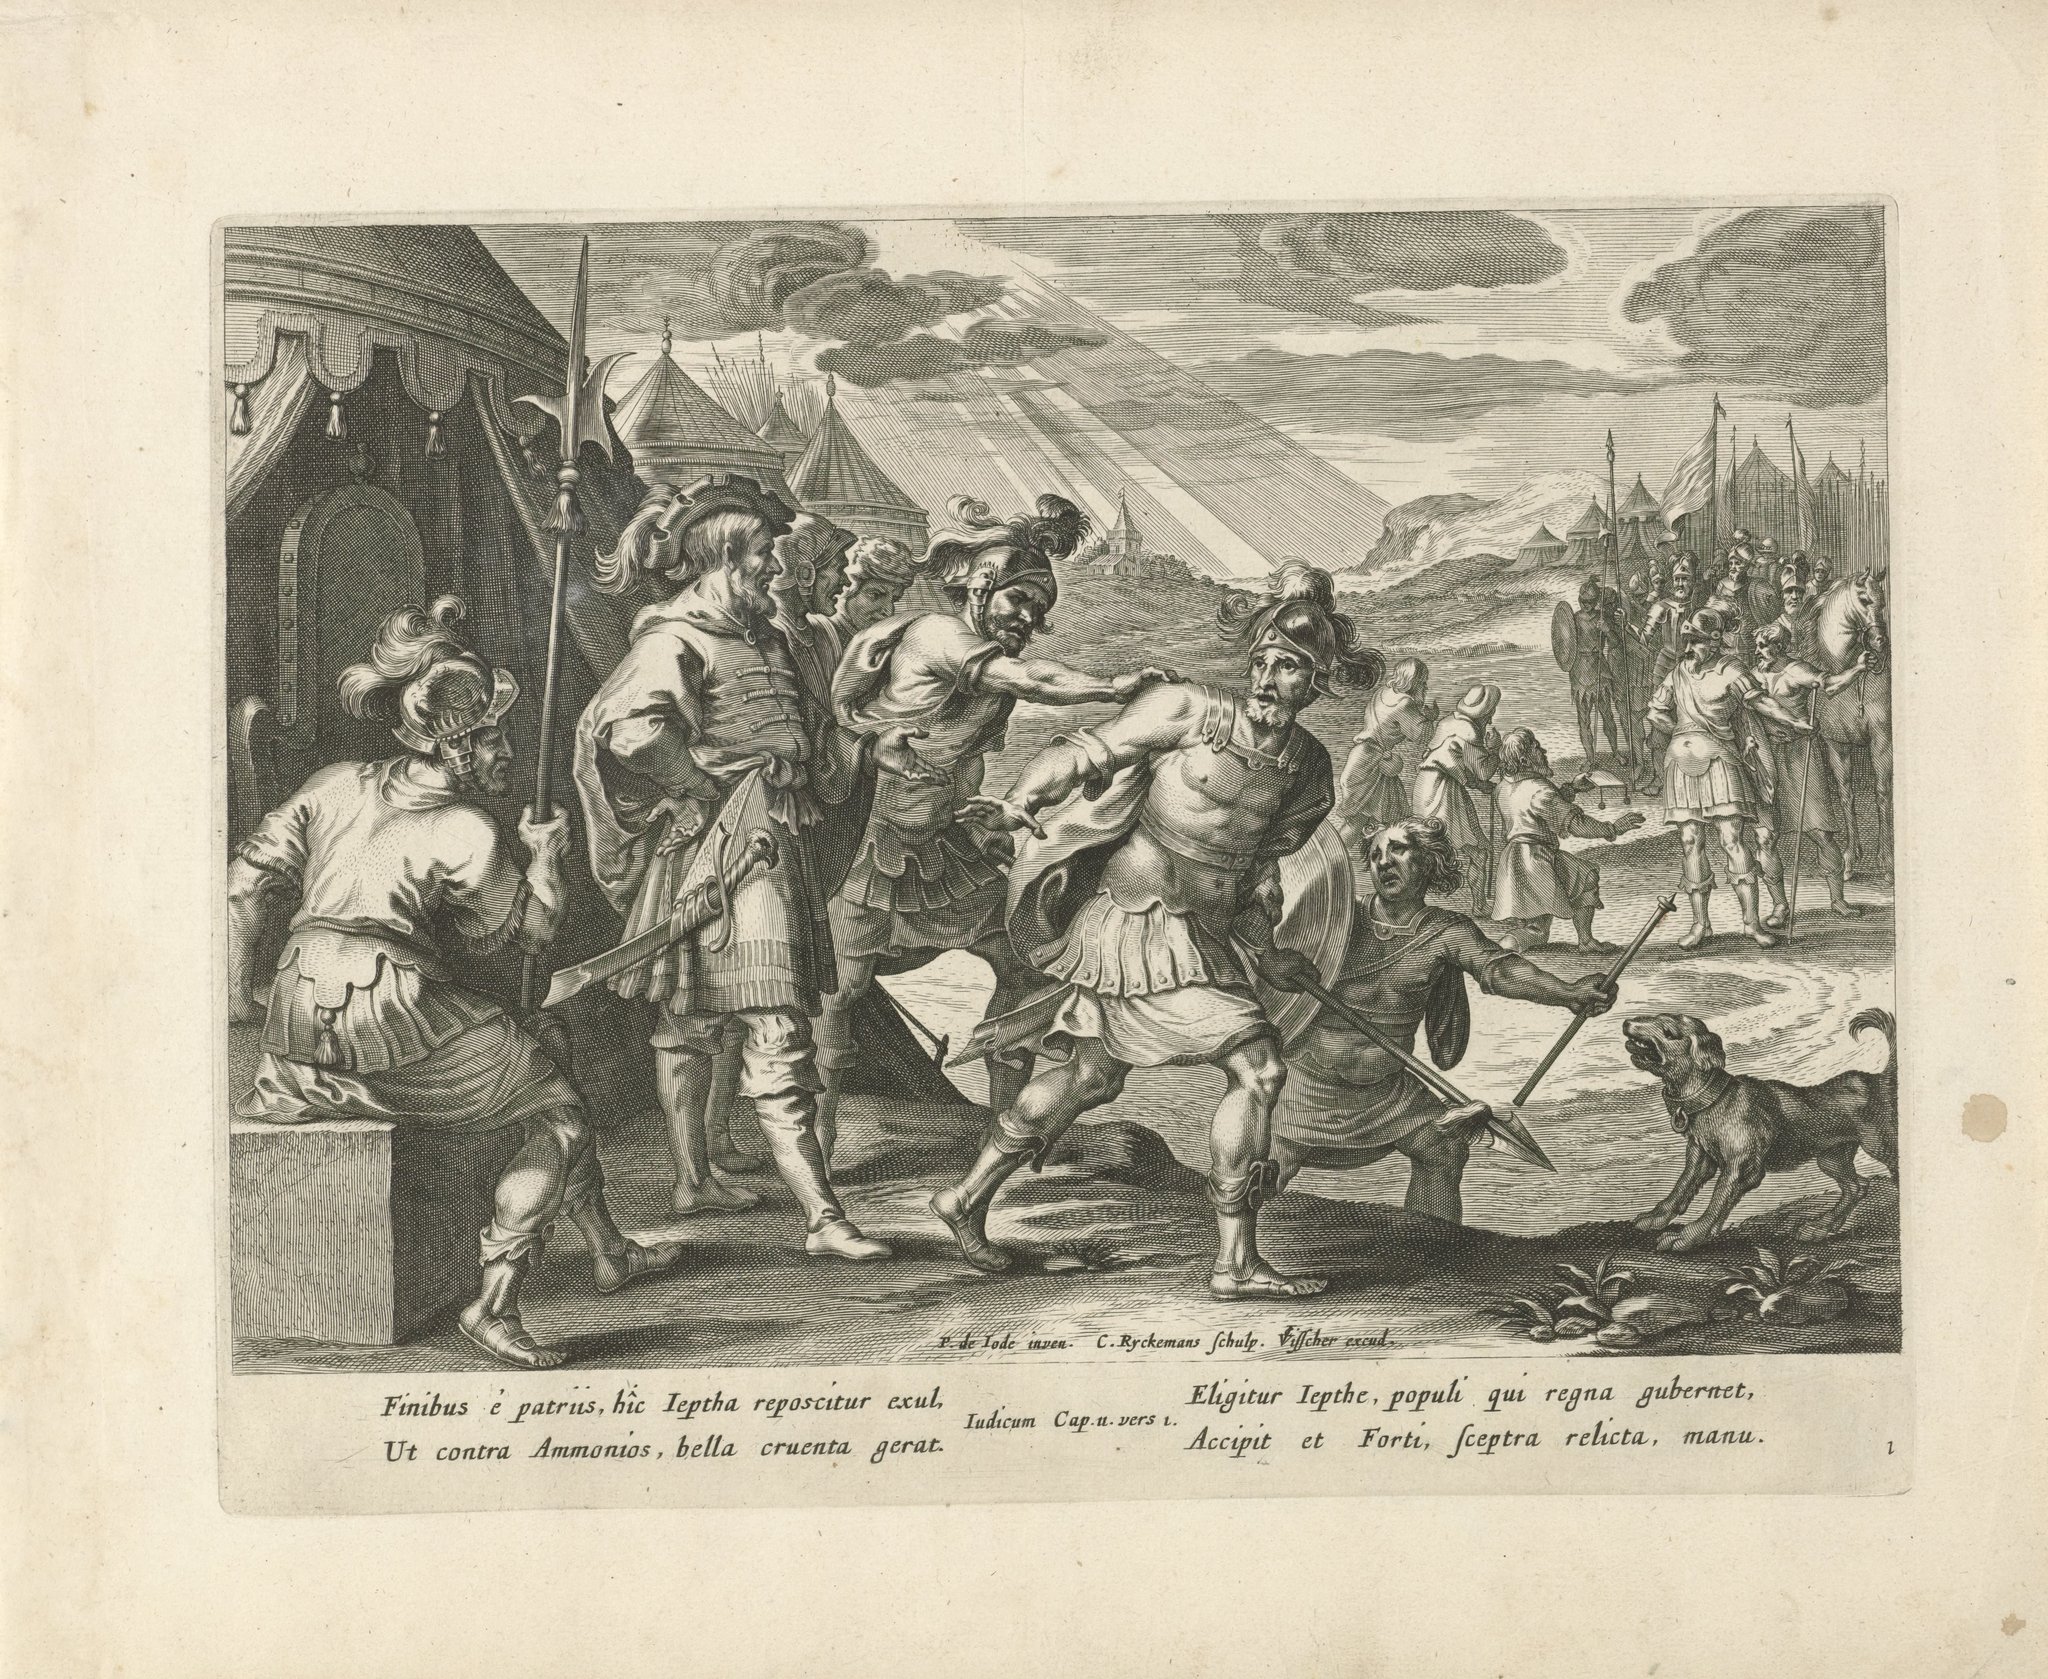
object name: print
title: Geschiedenis van Jefta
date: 1643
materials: paper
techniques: engraving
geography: amsterdam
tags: jephthah, son of gilead, is cast out by his brothers because he is the son of a harlot (judges 11:1-3), dog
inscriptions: collector's mark: Lugt 2228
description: Voor een legertent worden Jefta, met een spies in de hand, en zijn schildknaap door zijn broers verjaagd (Ri. 11:1-3). Jefta wordt uitgesloten omdat hij een andere moeder dan zijn broers heeft.